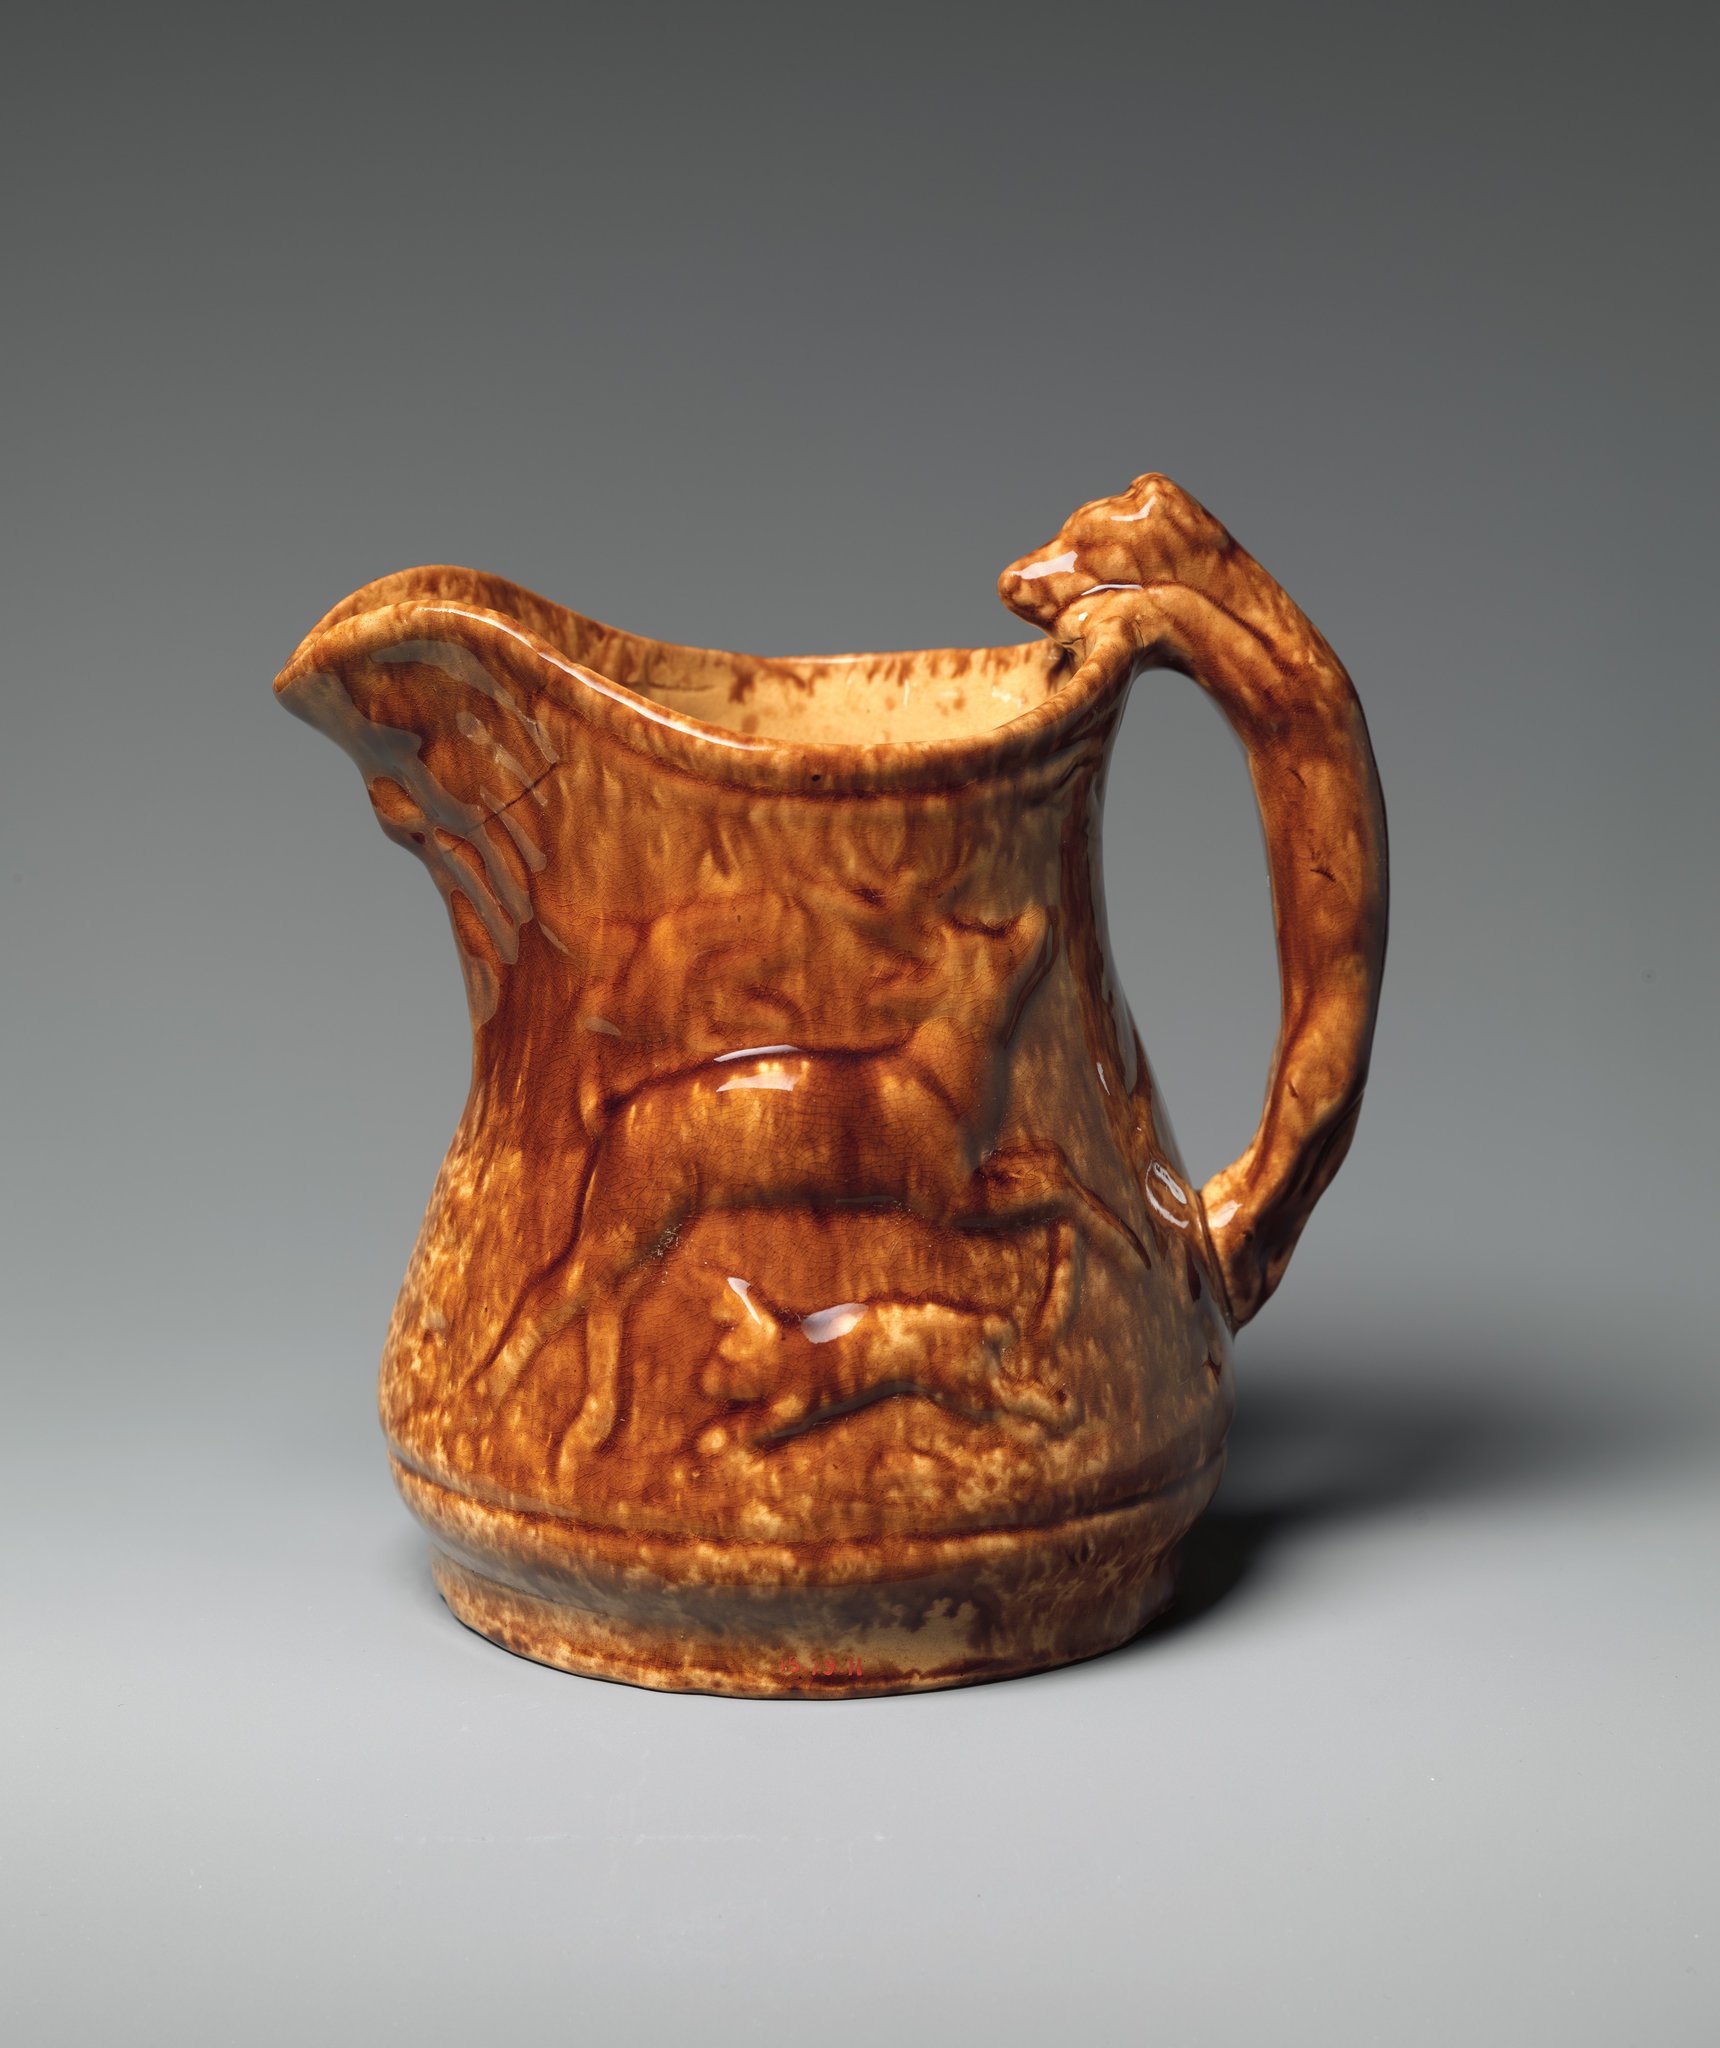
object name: pitcher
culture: american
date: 1850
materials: earthenware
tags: animals,boars,deer,dogs